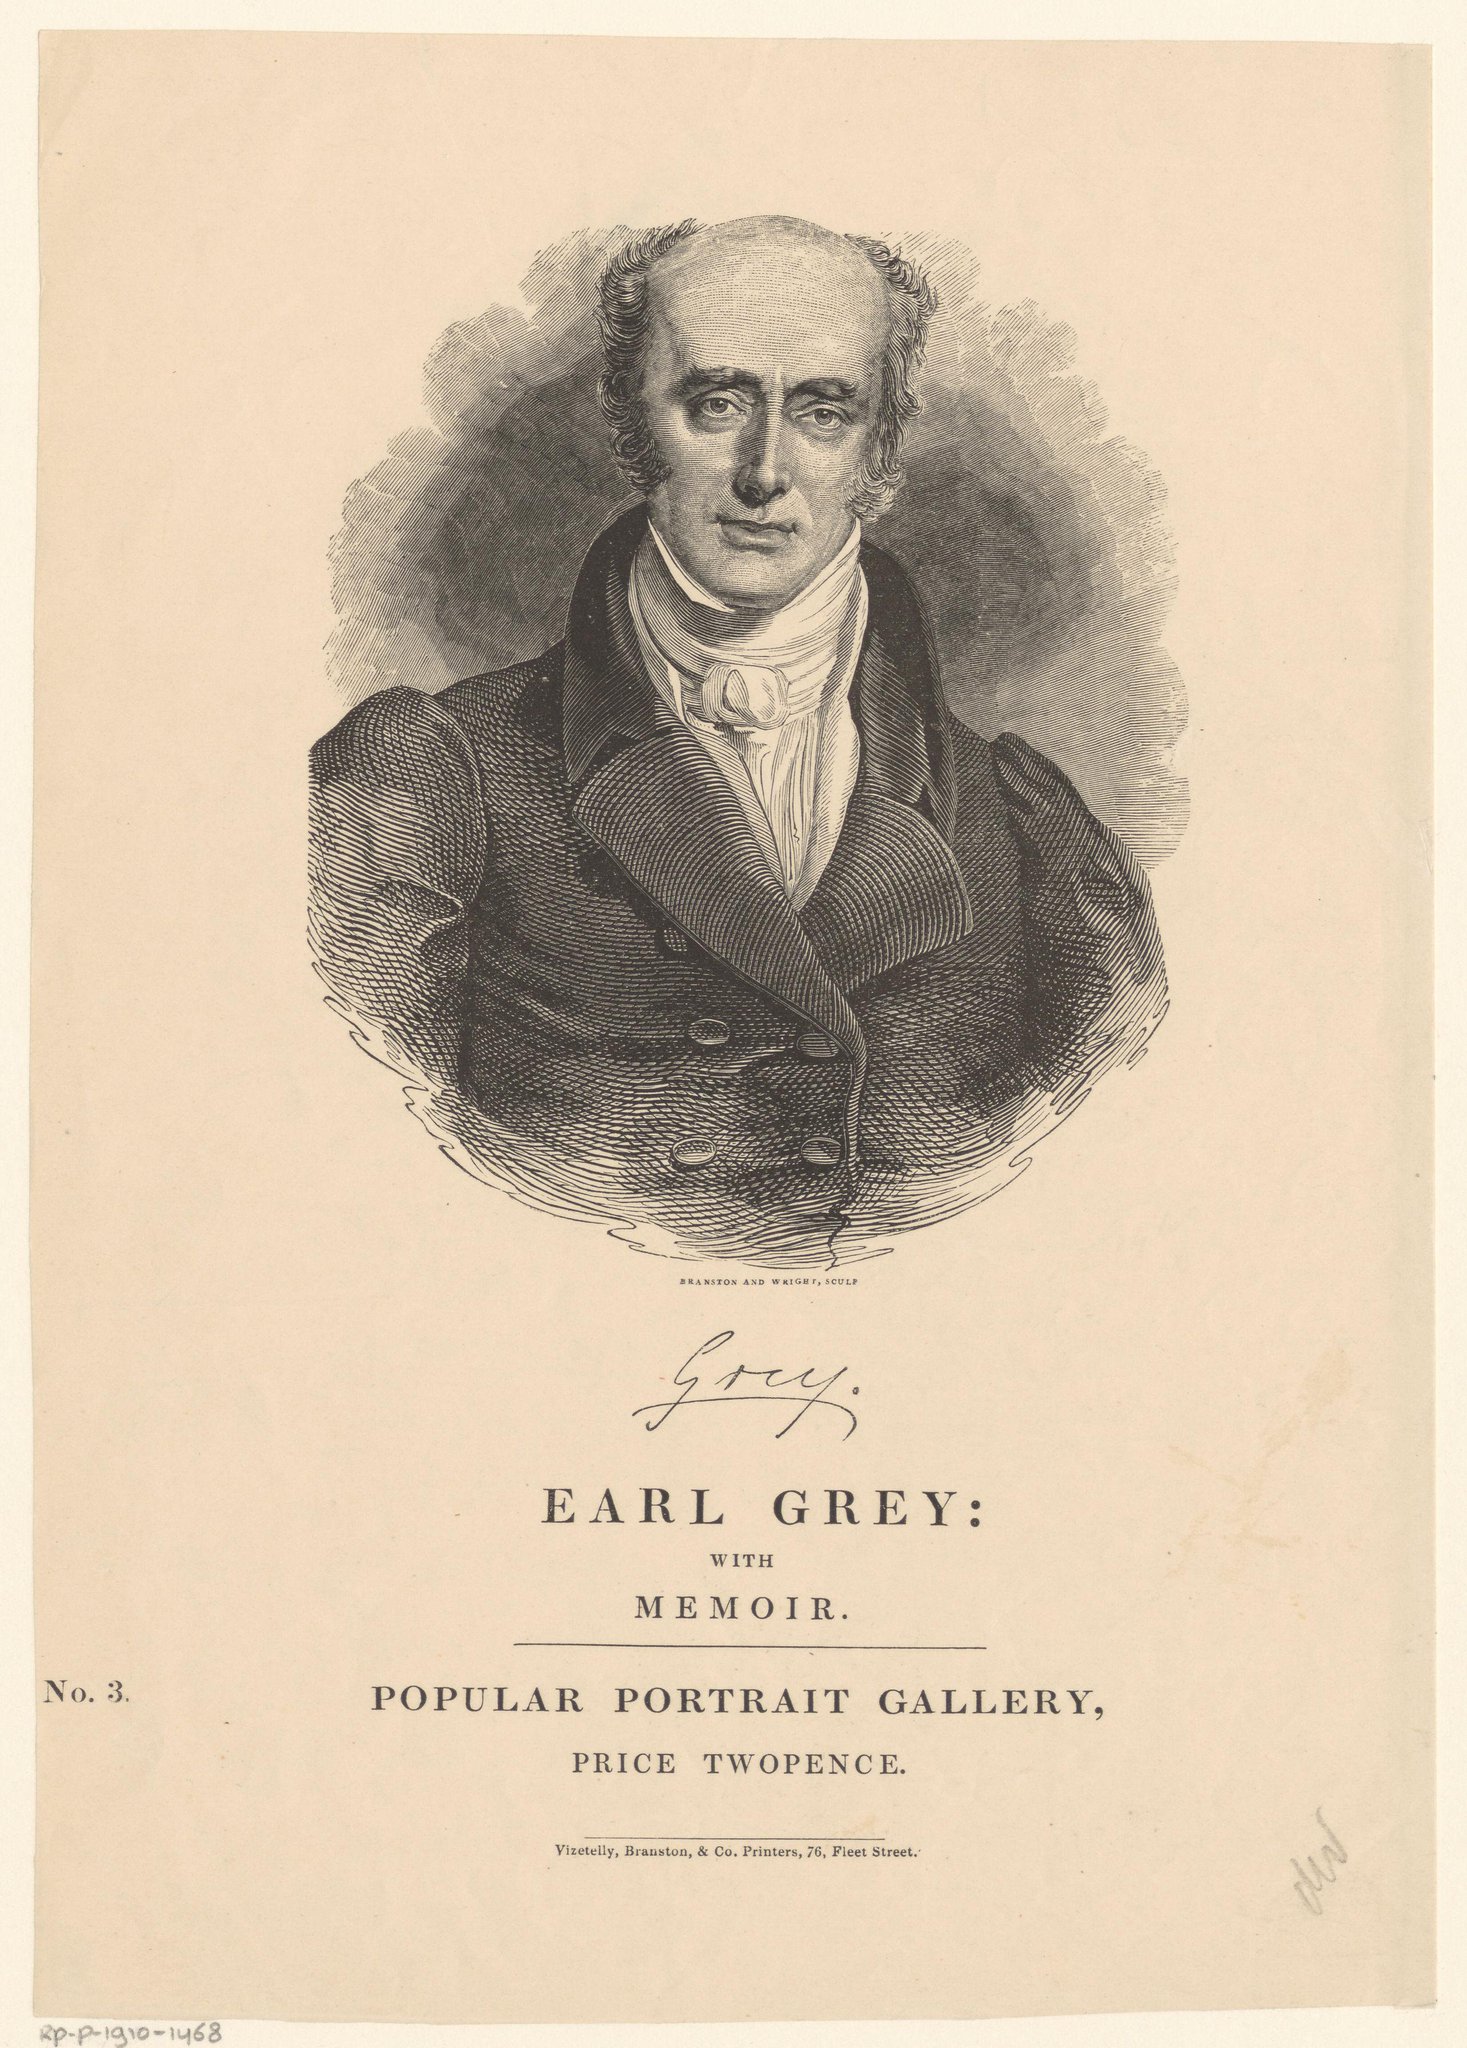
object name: print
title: Portret van Charles Grey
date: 1788-1827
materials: paper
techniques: engraving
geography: london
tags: politician, historical persons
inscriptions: collector's mark: Lugt 2228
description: Midden onder een facsimile van zijn handtekening.